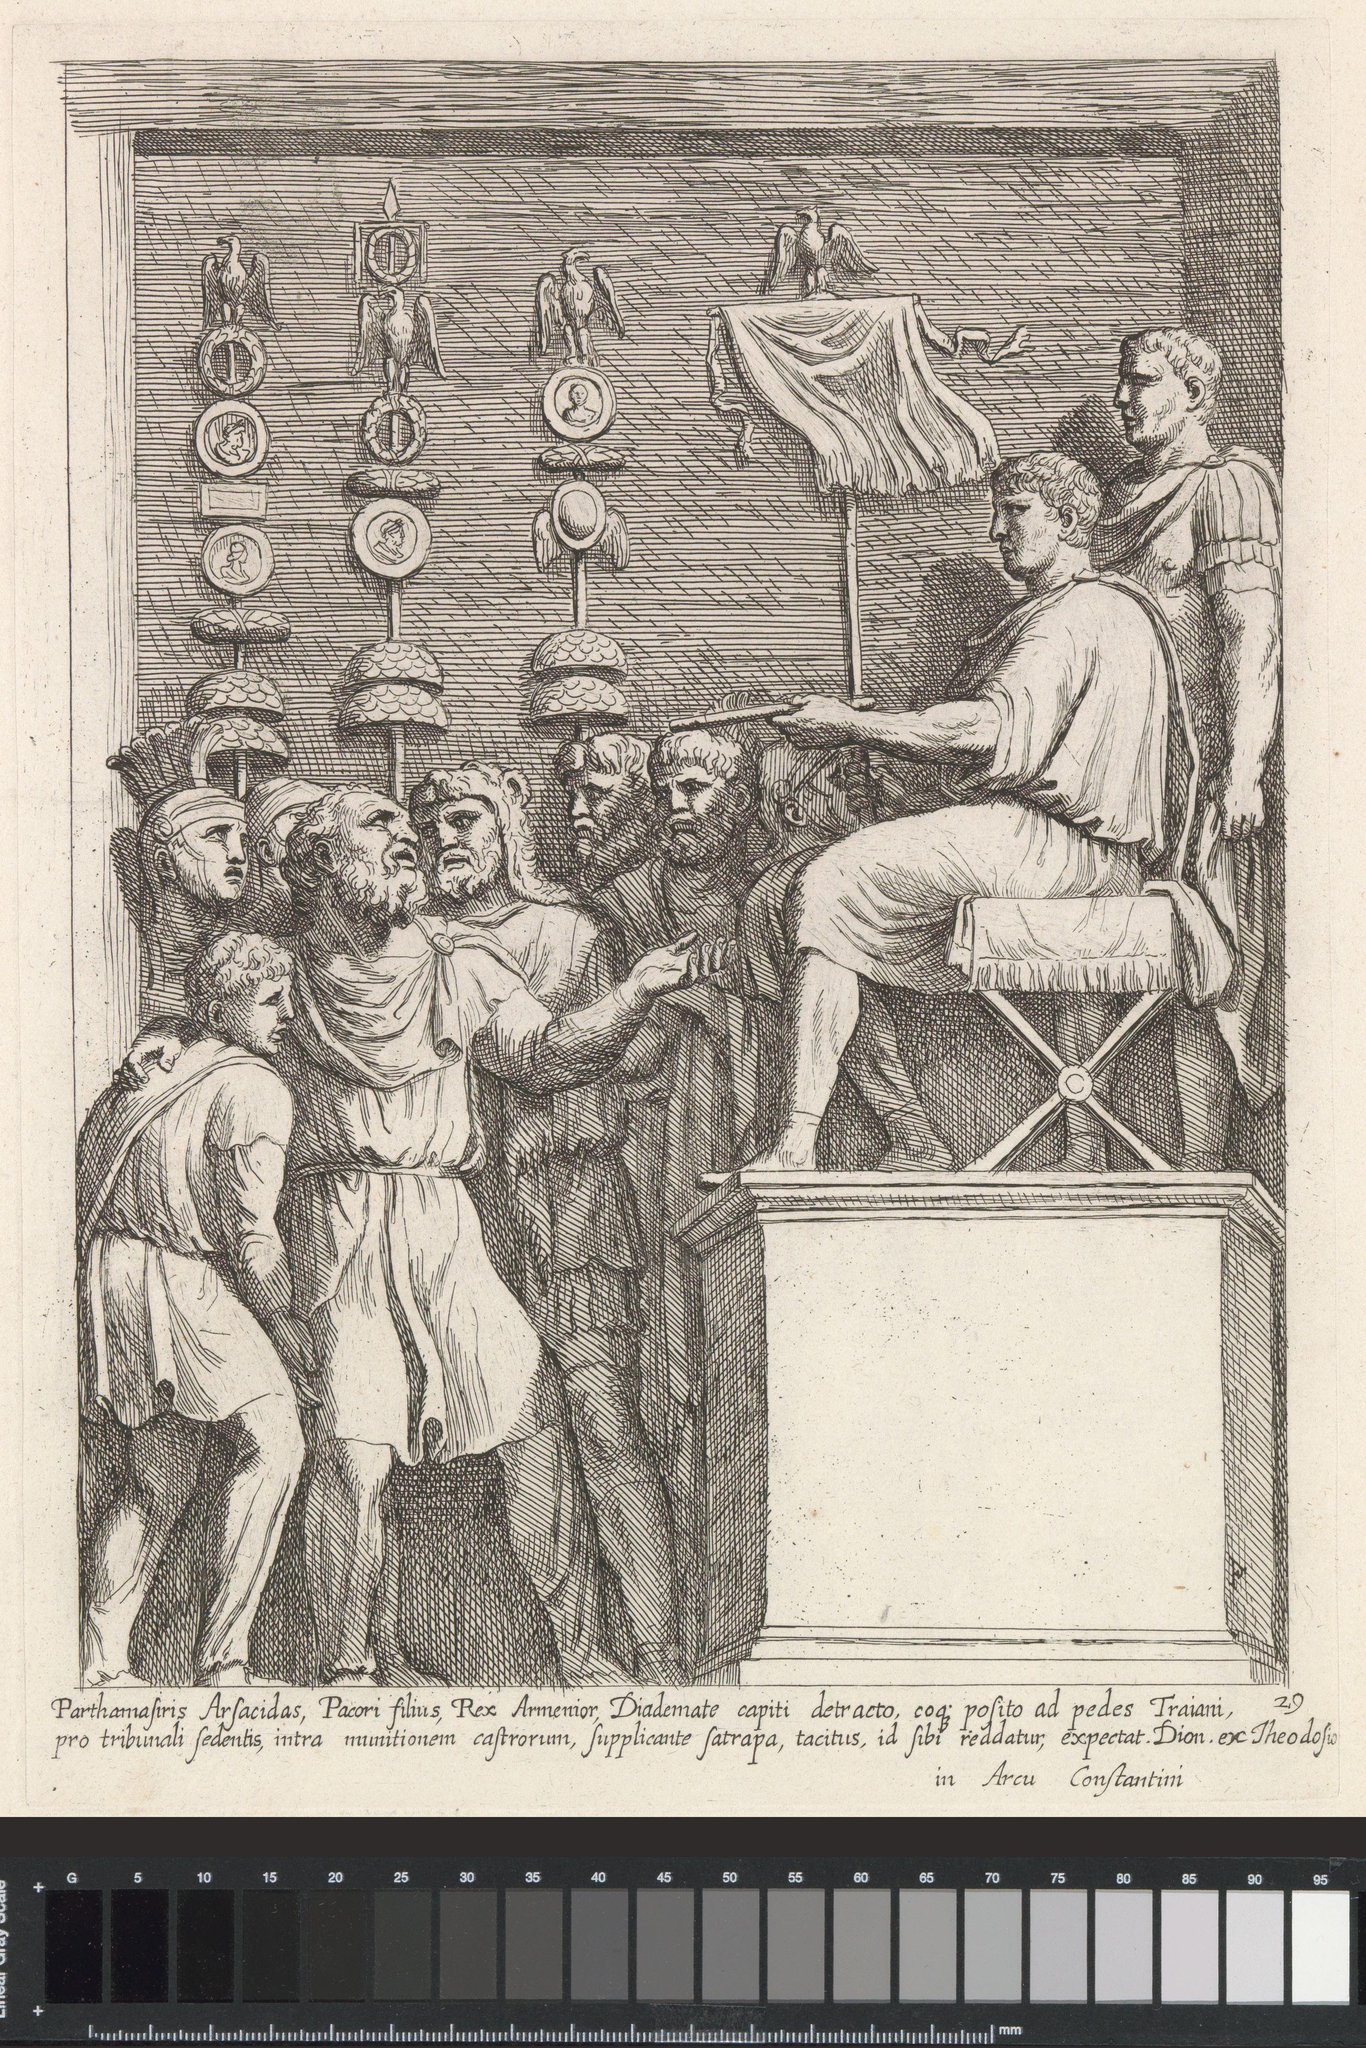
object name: print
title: Romeinse gebeeldhouwde reliëfs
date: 1645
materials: paper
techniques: etching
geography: paris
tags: piece of sculpture, reproduction of a piece of sculpture, the soldier; the soldier's life, ruler, sovereign, prisoner of war (after the battle), arch of constantine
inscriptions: inscription: ‘Ende lib. No. 6. tom. 2 No. 92.’, number: ‘56’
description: Deze prent maakt deel uit van een reeks van 54 prenten (+ titelprent) naar antieke reliëfs. De nummering op de prenten loopt van 1 tot en met 50. Sommige prenten hebben dubbele nummers. Naar de reliëfs op de Boog van Constantijn te Rome.